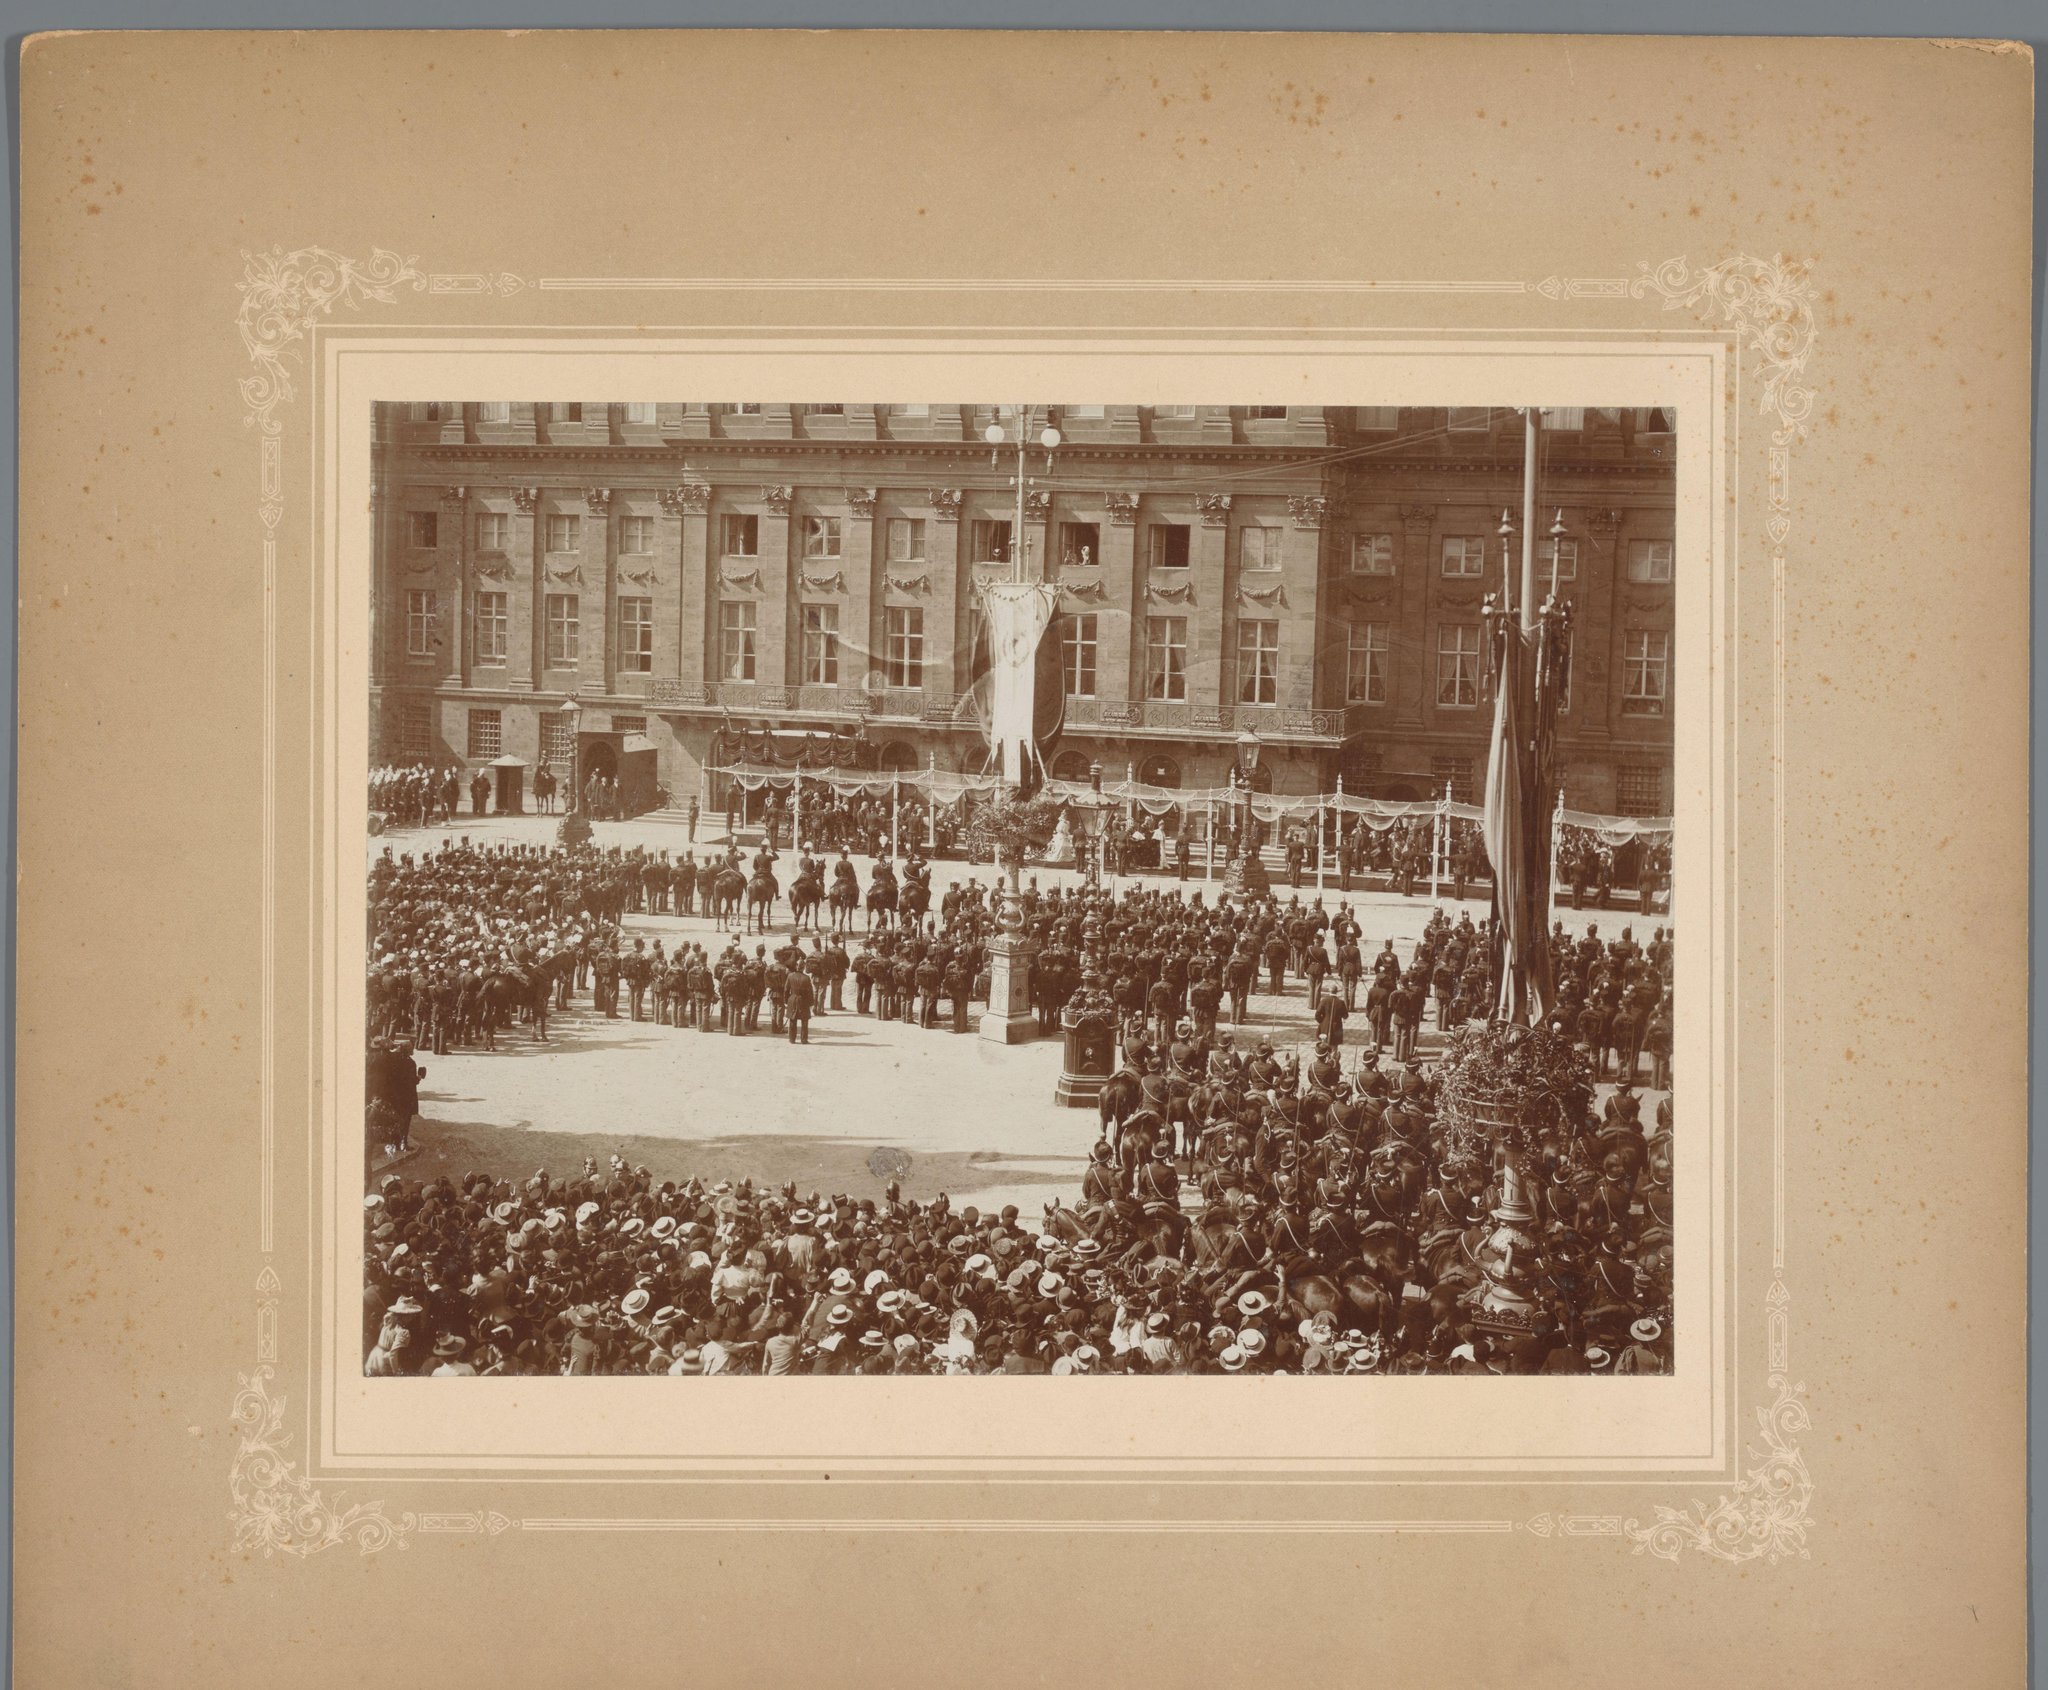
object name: photograph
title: Koningin Wilhelmina onder het baldakijn na haar inhuldiging in Amsterdam onder toeziend oog van een grote menigte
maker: Anonymous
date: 1898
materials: paper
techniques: albumen print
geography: amsterdam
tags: the hague, print maker, wilhelmina of the netherlands, amsterdam